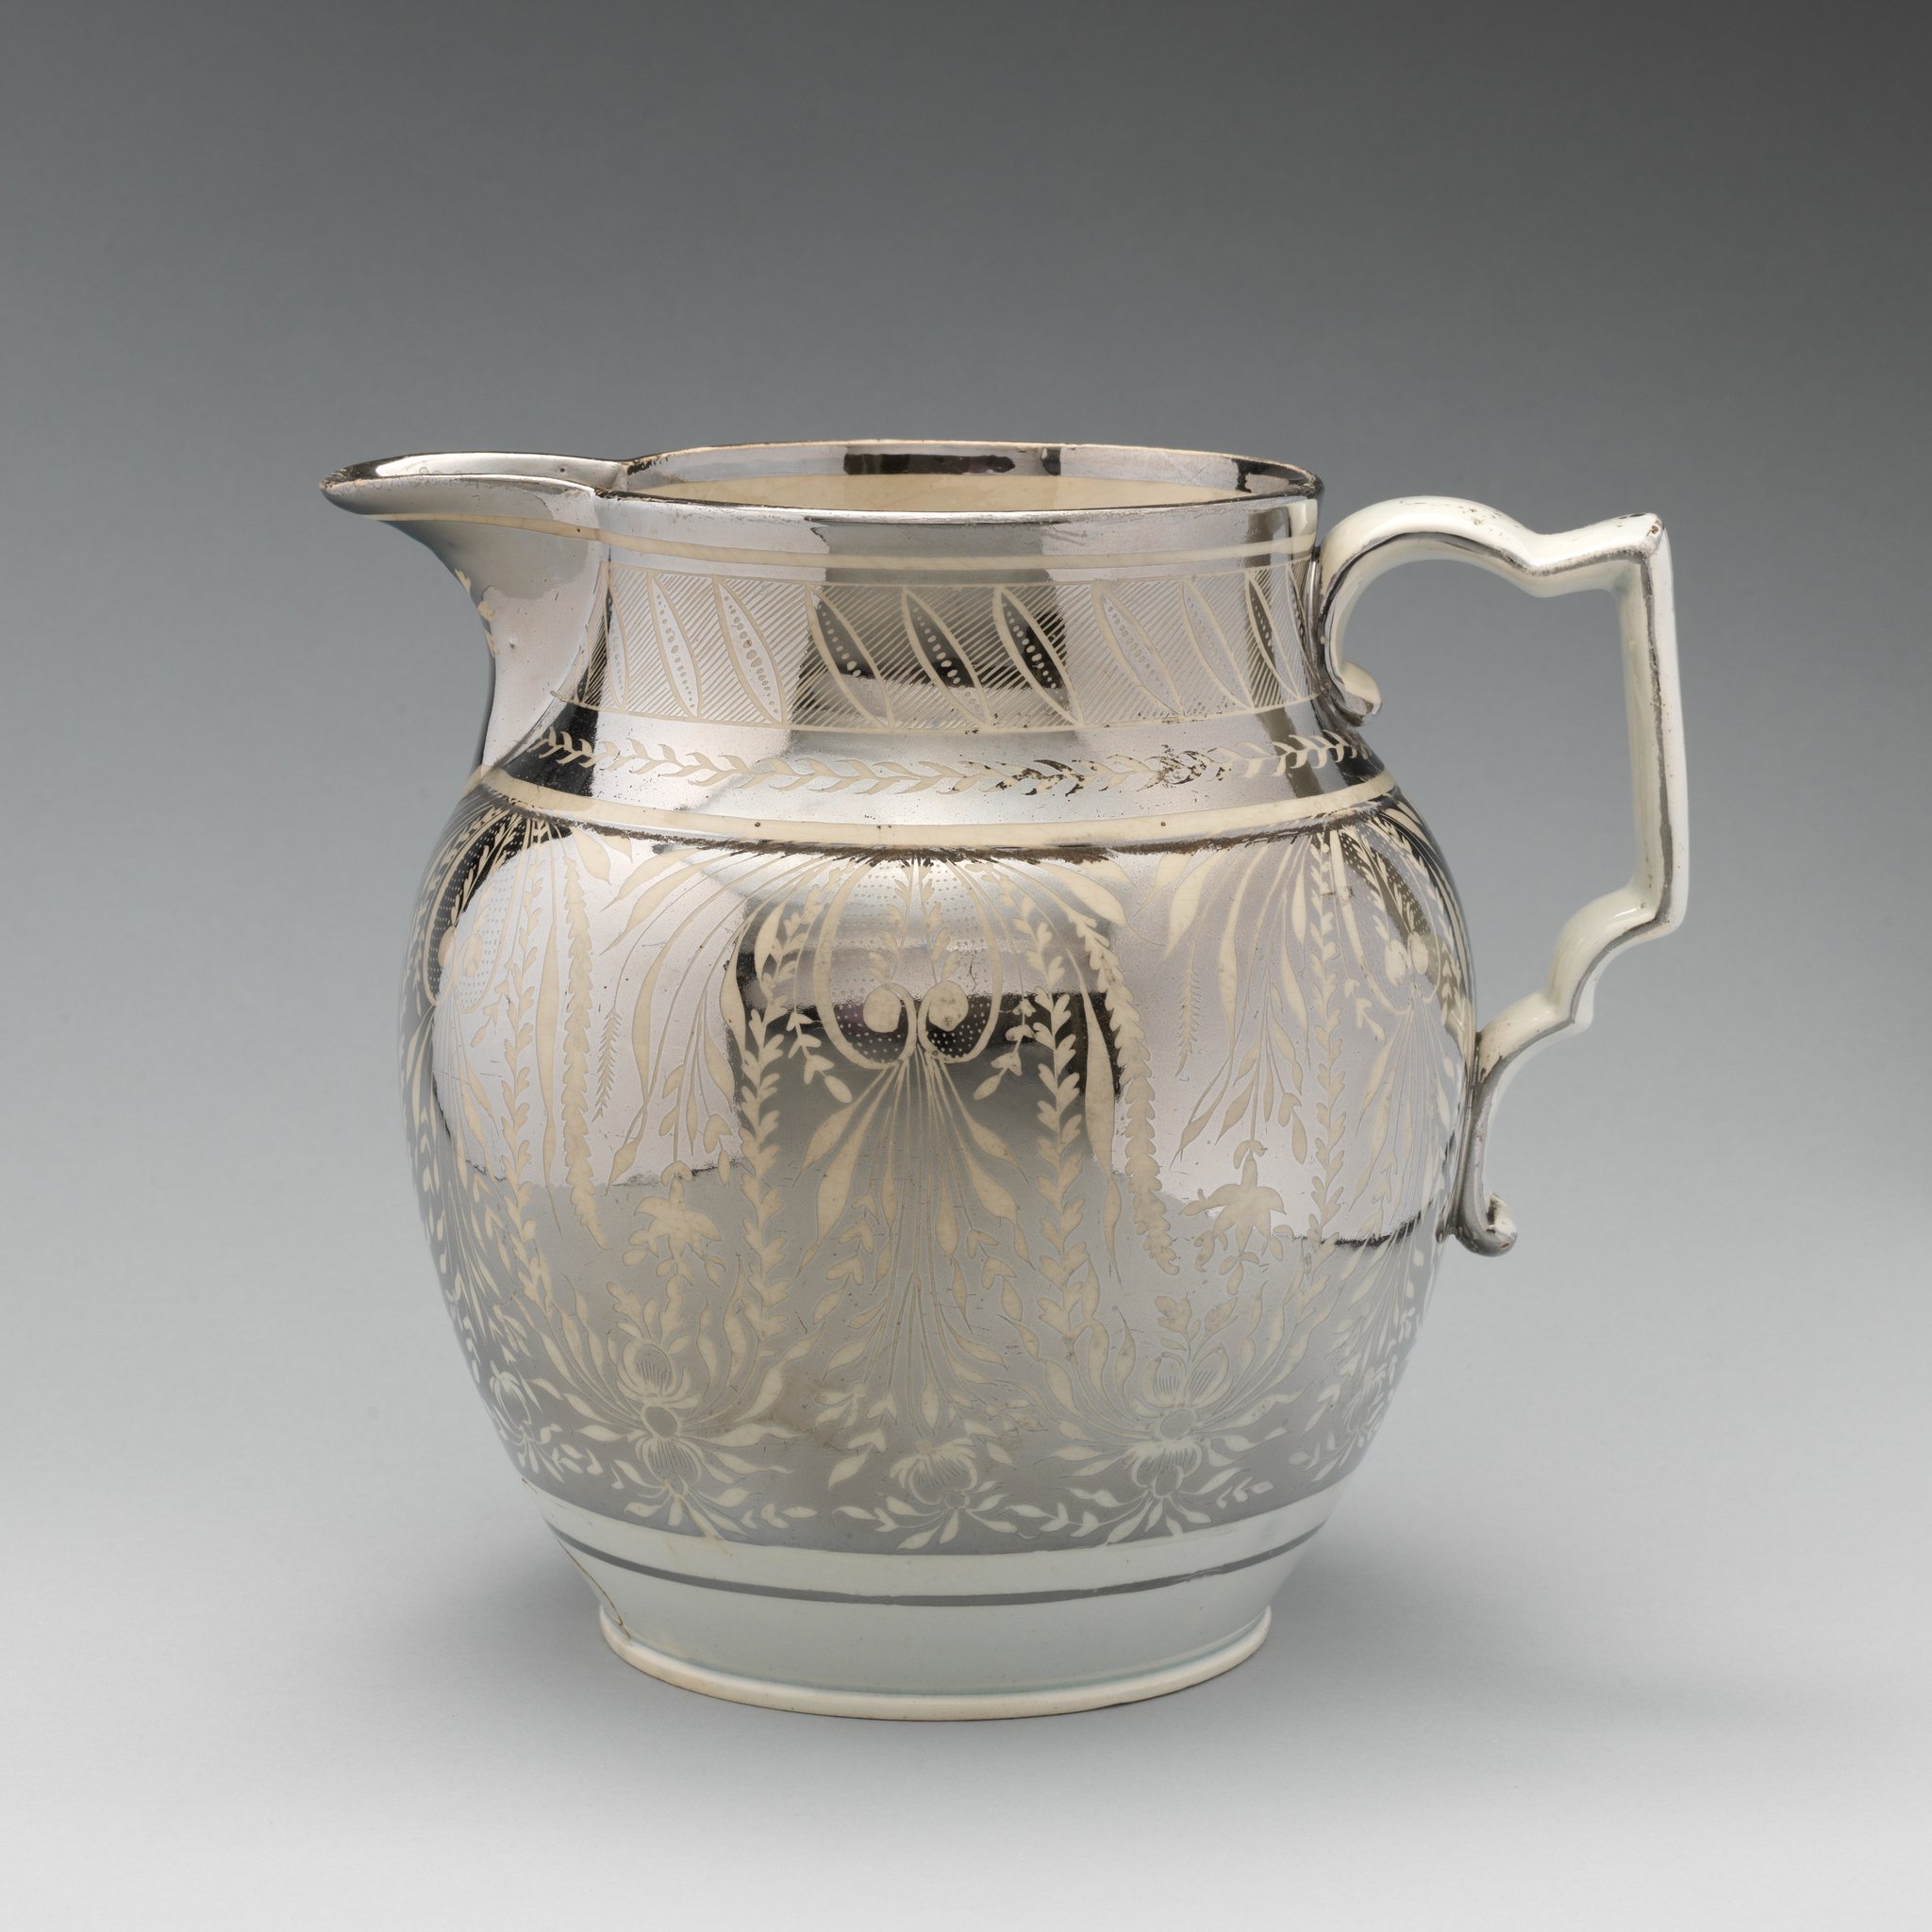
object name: jug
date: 1801-1833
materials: earthenware